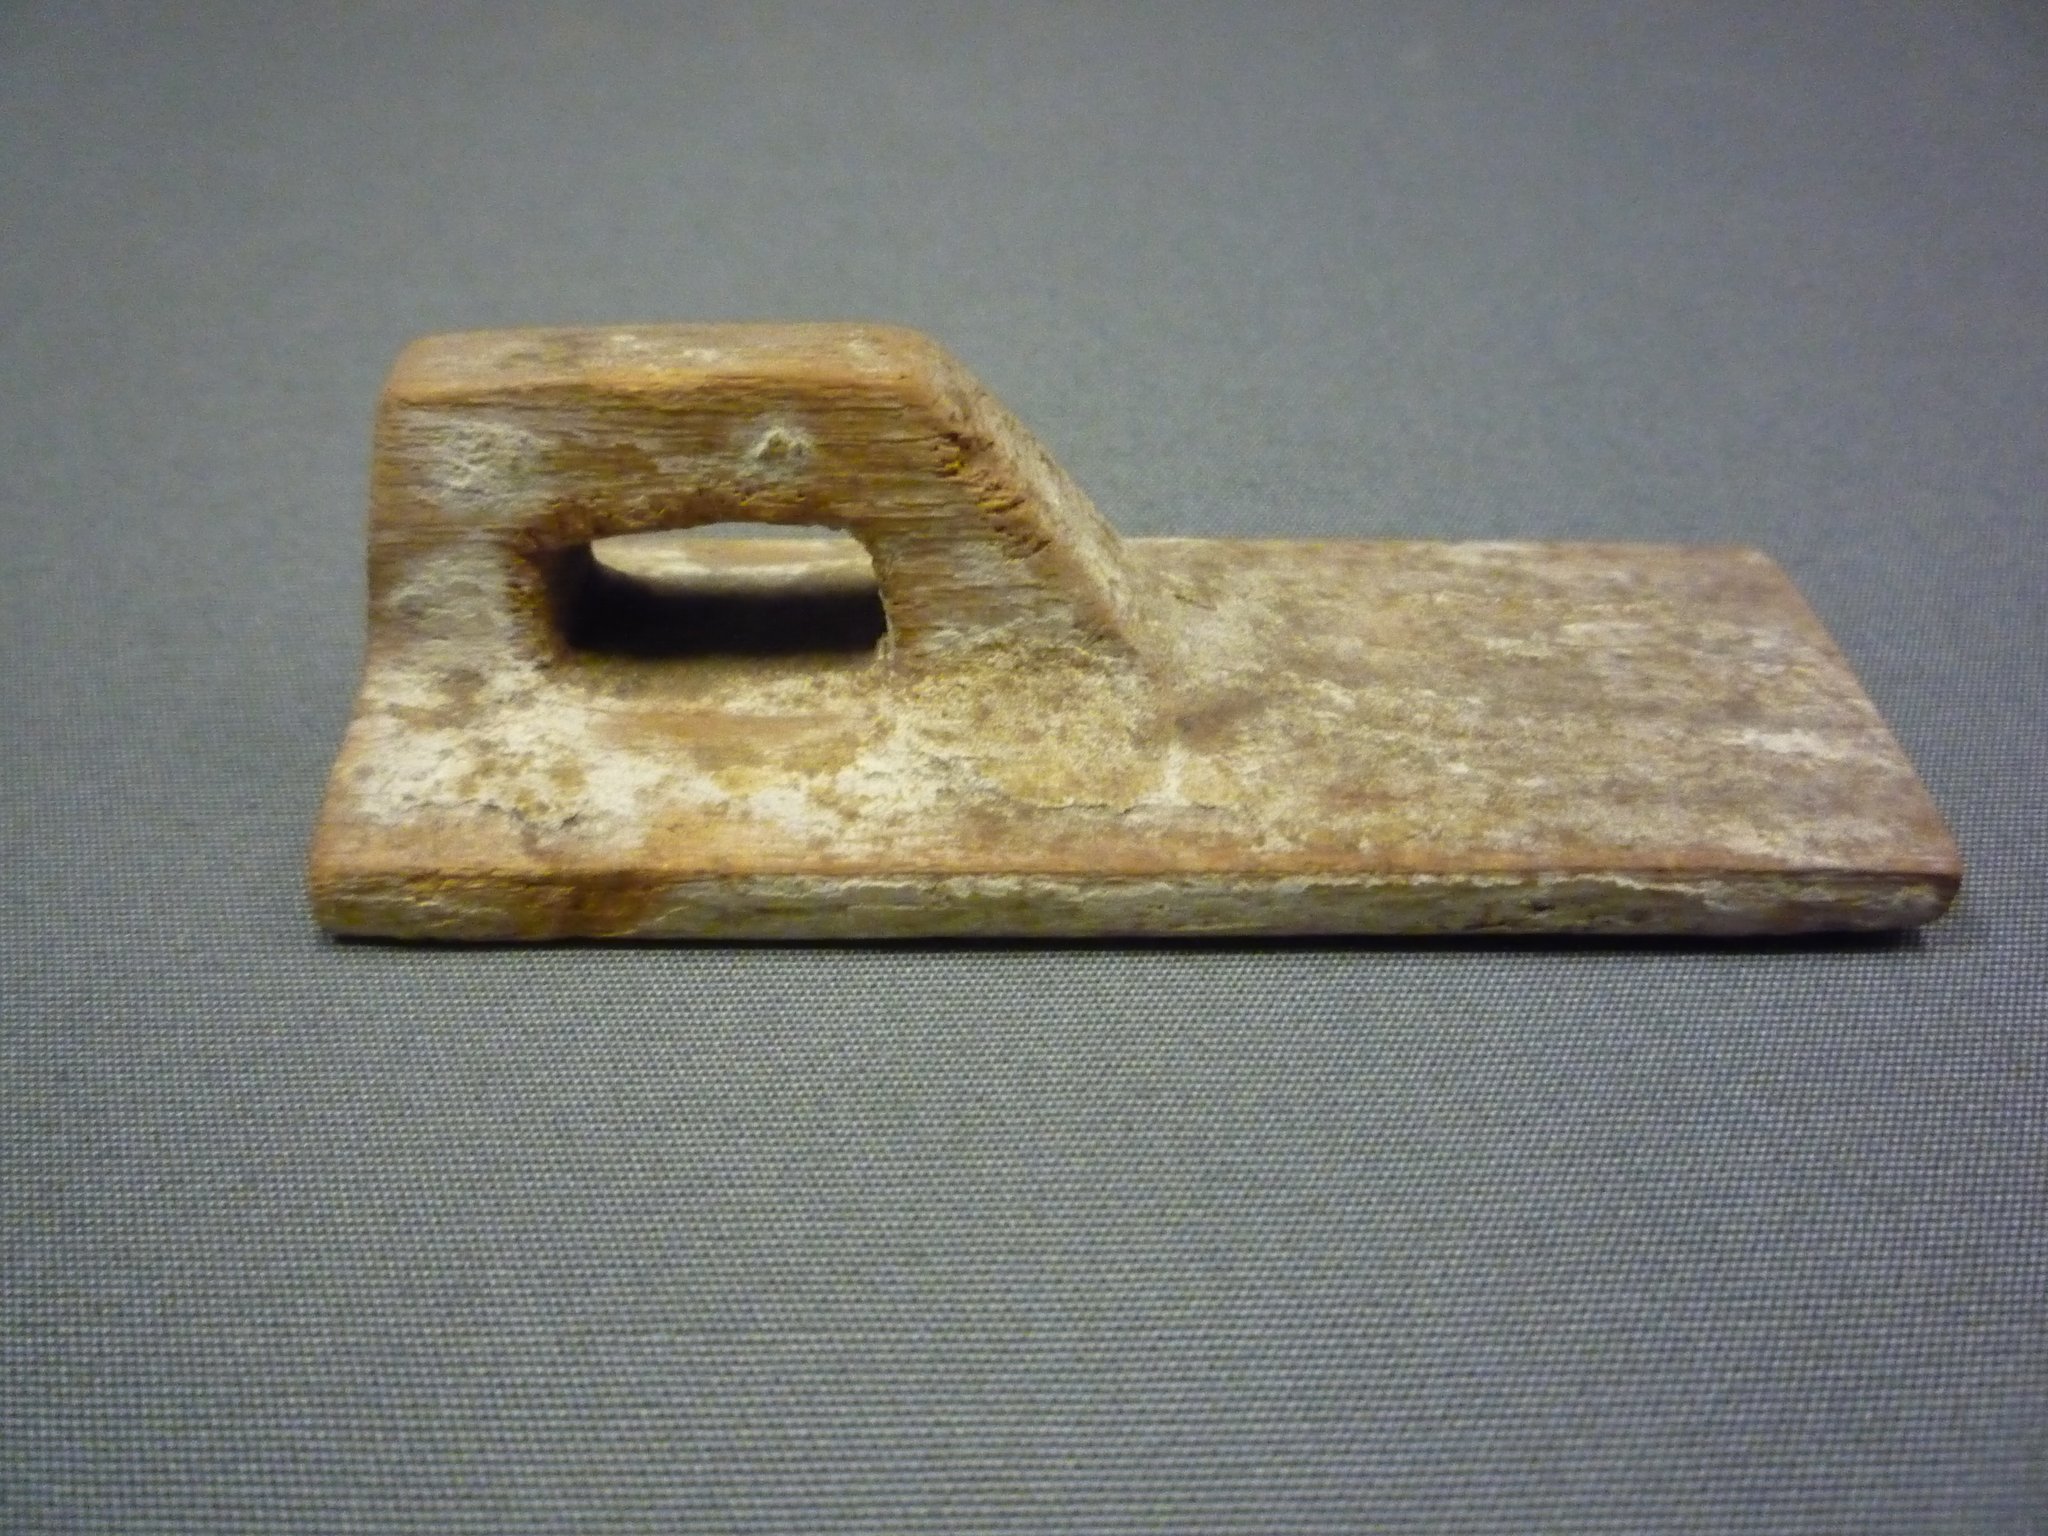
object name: model float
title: Model Mason's Float from the Foundation Deposit for Hatshepsut's Tomb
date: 1479-1458 BCE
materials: paint, wood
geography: egypt